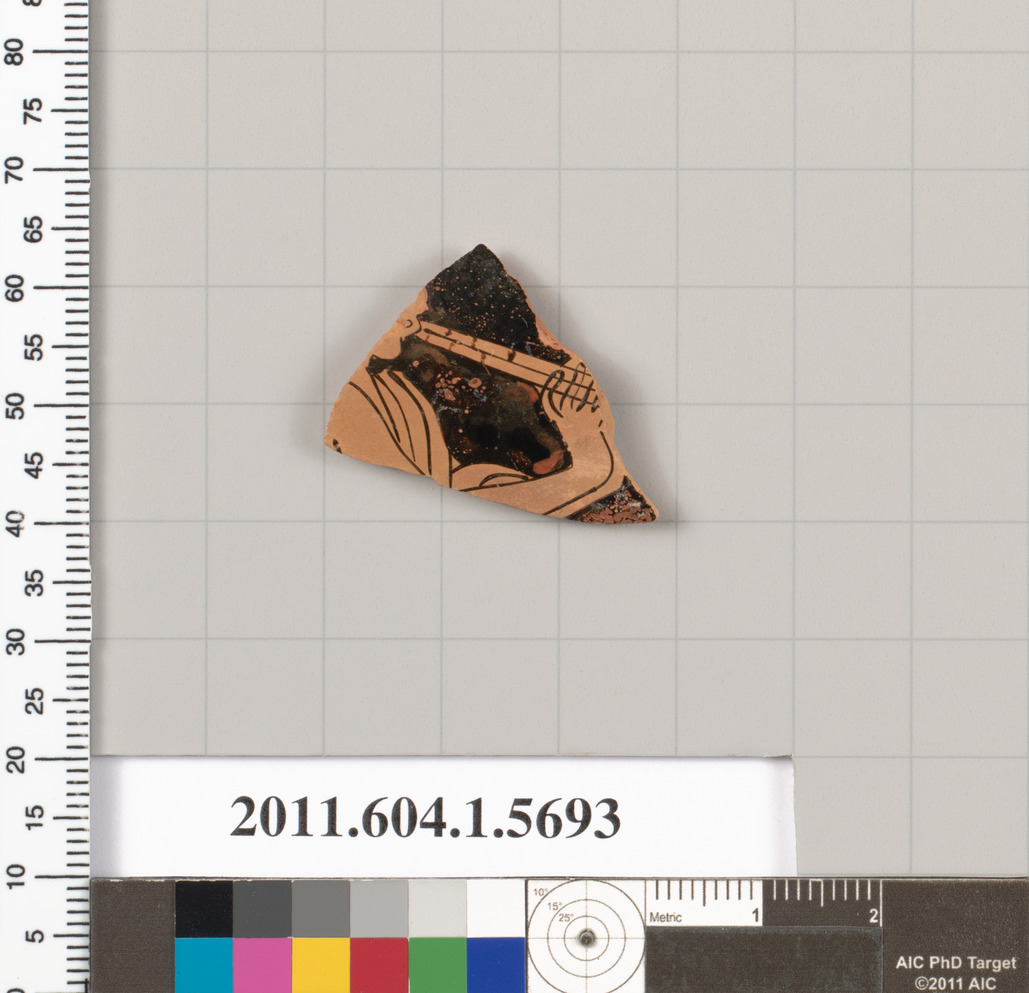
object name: kylix fragment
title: Terracotta fragment of a kylix (drinking cup)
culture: greek, attic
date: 490-470 BCE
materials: terracotta